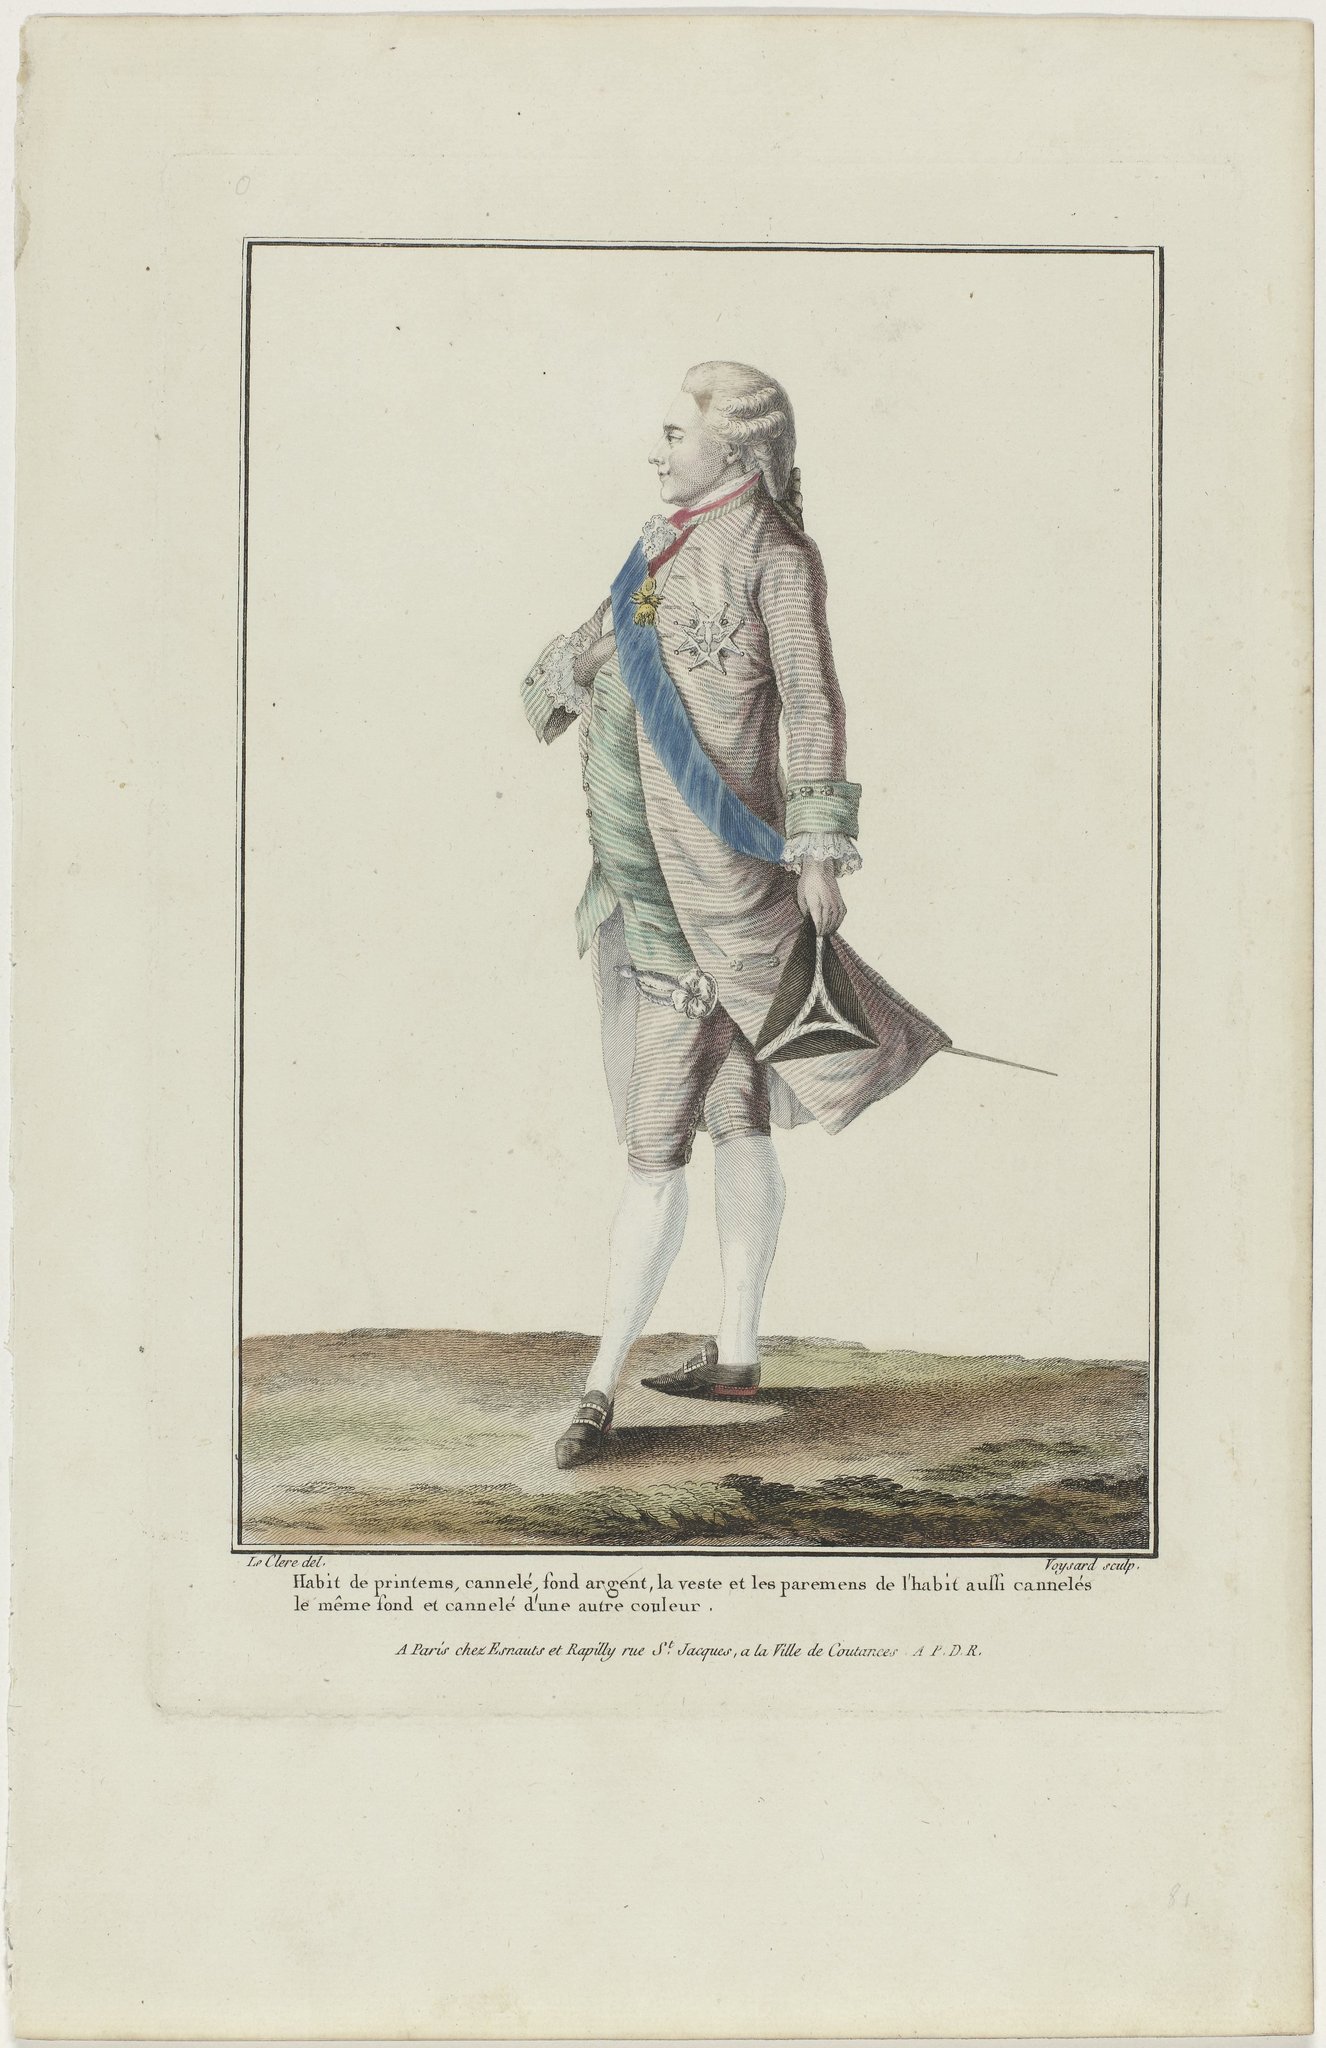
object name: fashion print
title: Gallerie des Modes et Costumes Français, 1778, O 81 : Habit de printemps (...)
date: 1778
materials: paper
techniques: engraving, hand coloring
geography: paris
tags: head-gear: tricorn (+ men's clothes), clothing for the upper part of the body (vest) (+ men's clothes), coat (+ men's clothes), styles of hairdress, fashion plates, shoes, sandals (+ men's clothes), trousers, breeches, etc. (breeches) (+ men's clothes), sleeves (+ men's clothes)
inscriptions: address: ‘A Paris chez Esnauts et Rapilly rue St. Jacques, a la Ville de Coutances.A.P.D.R.’, caption: ‘Habit de printemps, cannelé, fond argent, la veste et les paremens de l'habit aussi cannelés le même fond et cannelé d'une autre couleur.’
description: Man met gepoederde staartpruik, in een 'habit à la française' voor de lente: knielange jas (habit), vest en nauwe kuitbroek van dezelfde stof als de jas. Schoenen met rode hakken en gespen. Als decoraties de blauwe sjerp en het kruis van de orde van de H. Lodewijk en het ordeteken van het Gulden Vlies. Tricorne in de hand, sierdegen aan linkerzijde. Prent uit serie O. 14e Cahier de Costumes Français, 8e Suite d'Habillemens à la mode en 1778, Gallerie des Modes et Costumes Français.